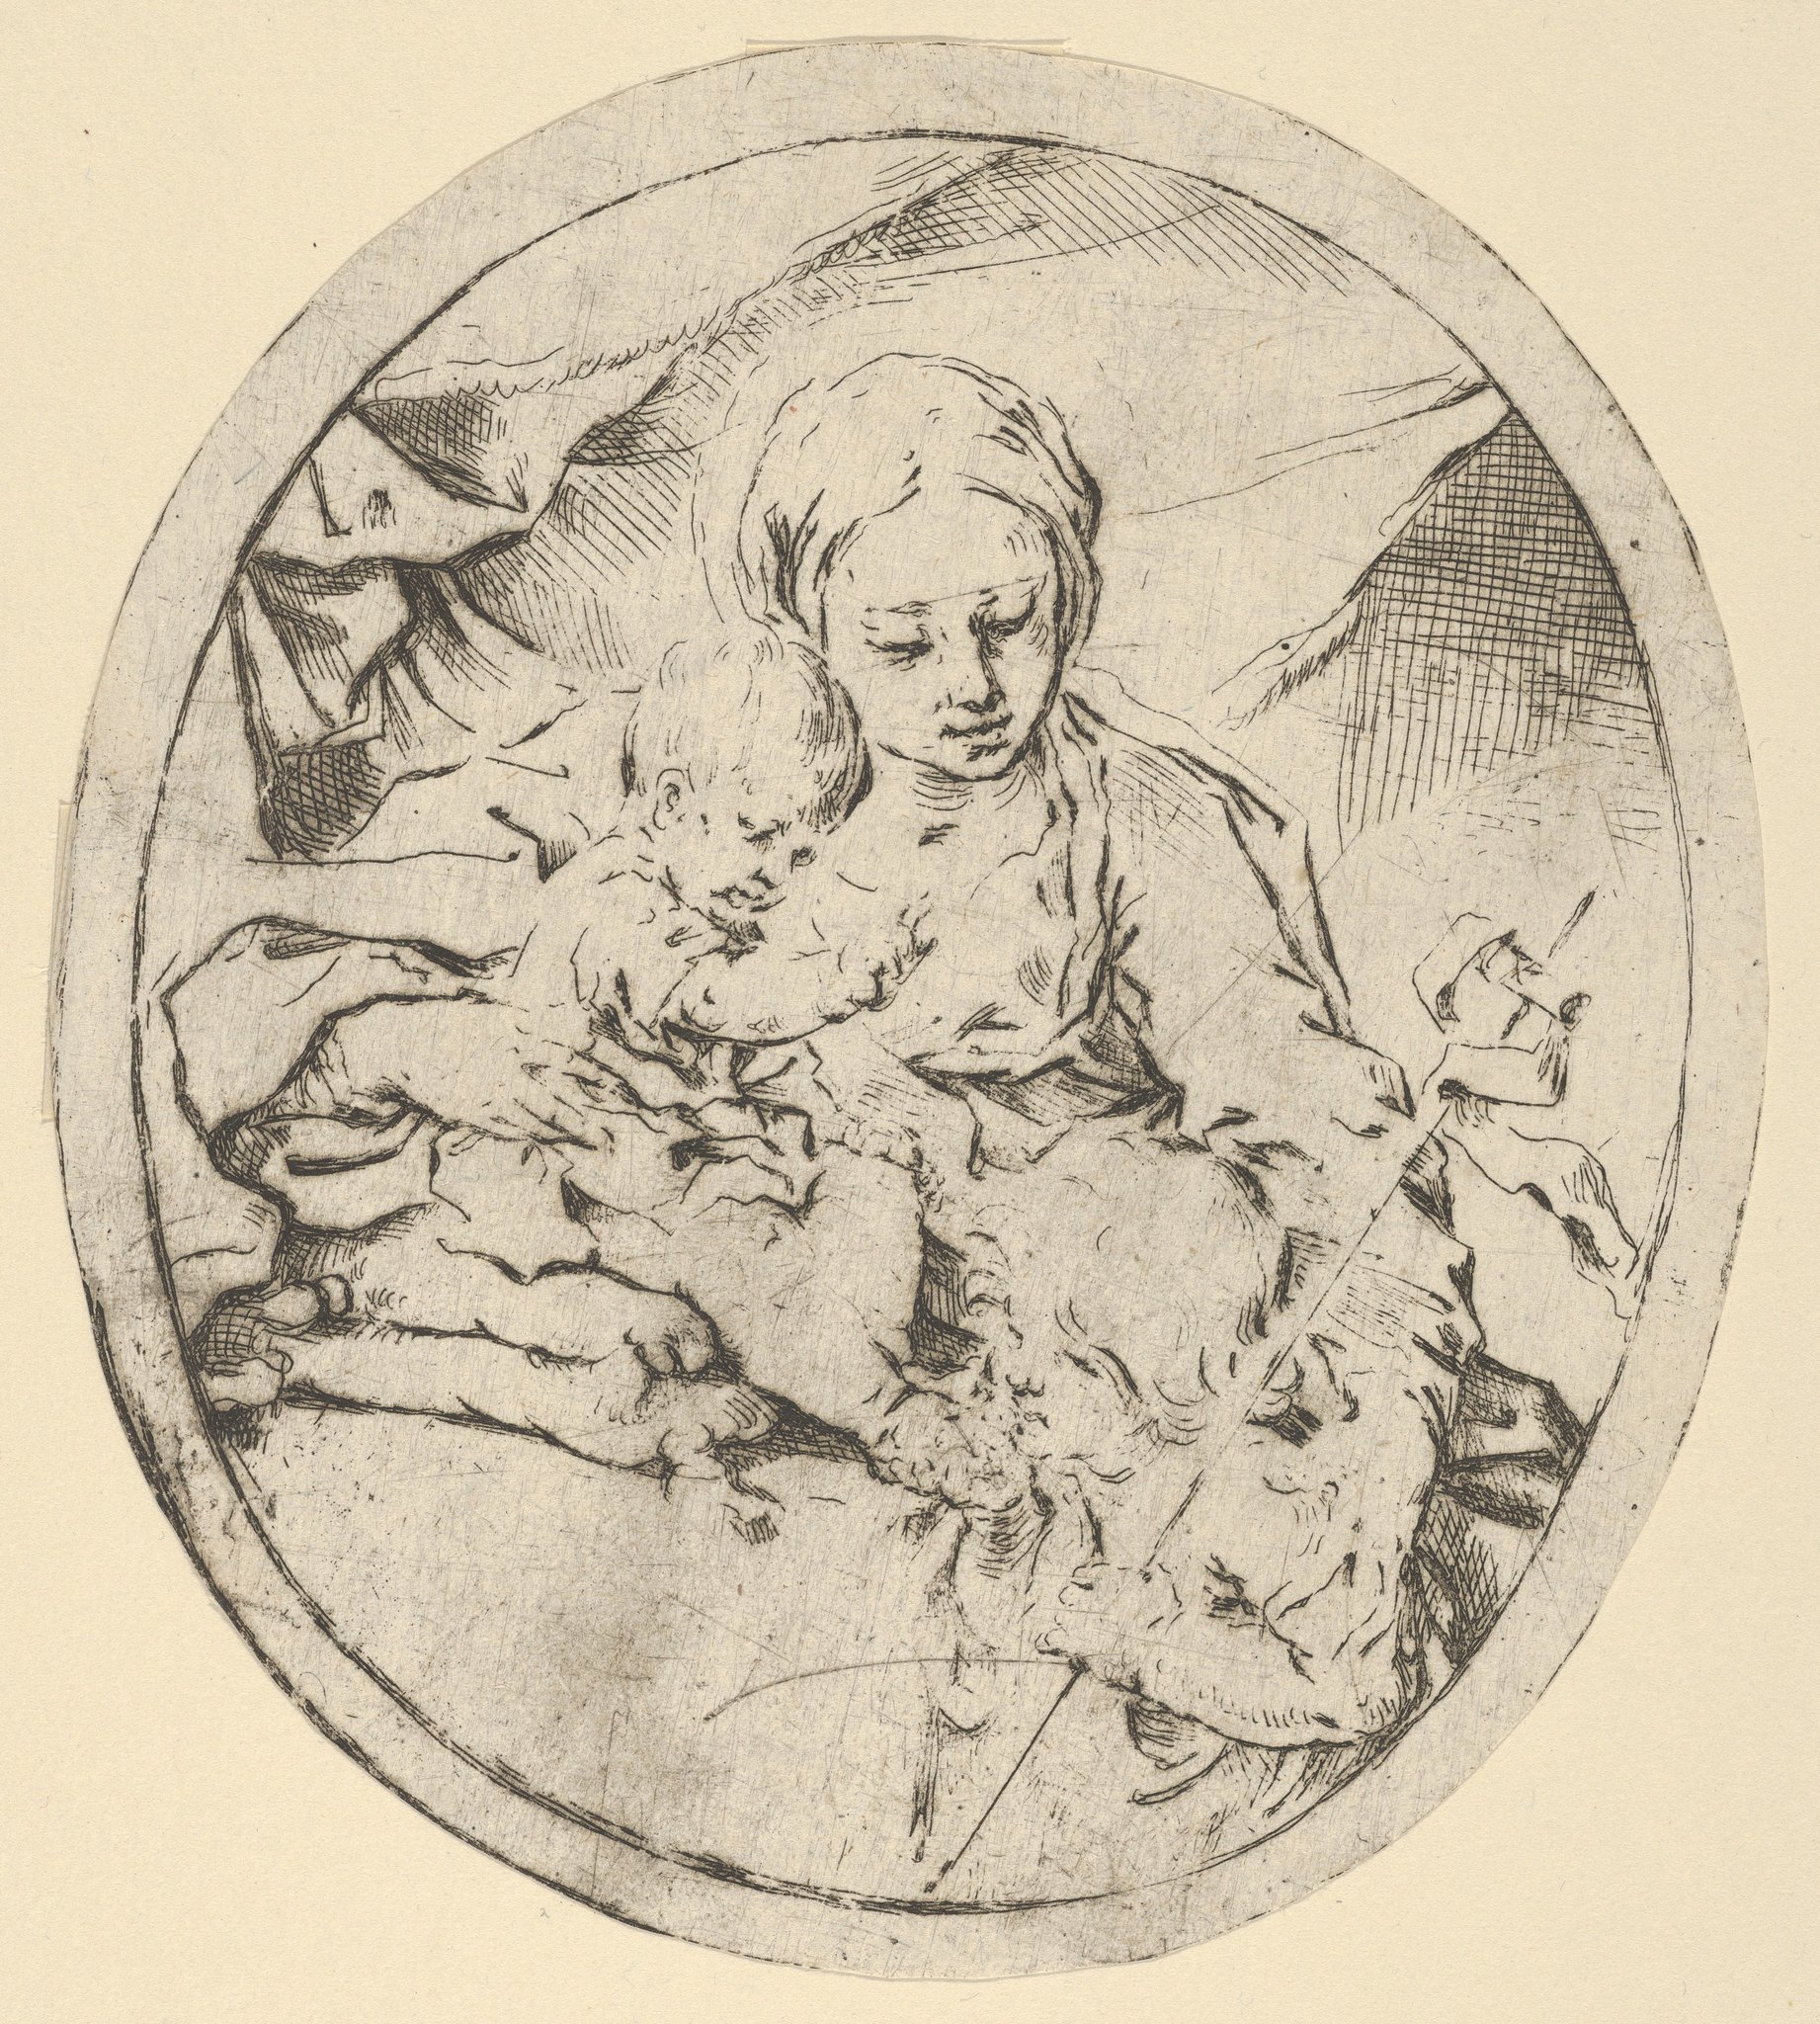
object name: print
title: The Virgin with the infant Christ seated on a cushion and the young Saint John the Baptist at his feet, an oval composition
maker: guido reni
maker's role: artist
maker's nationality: italian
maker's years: 1575-1642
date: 1600-1640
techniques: etching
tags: christ,saint john the baptist,virgin mary